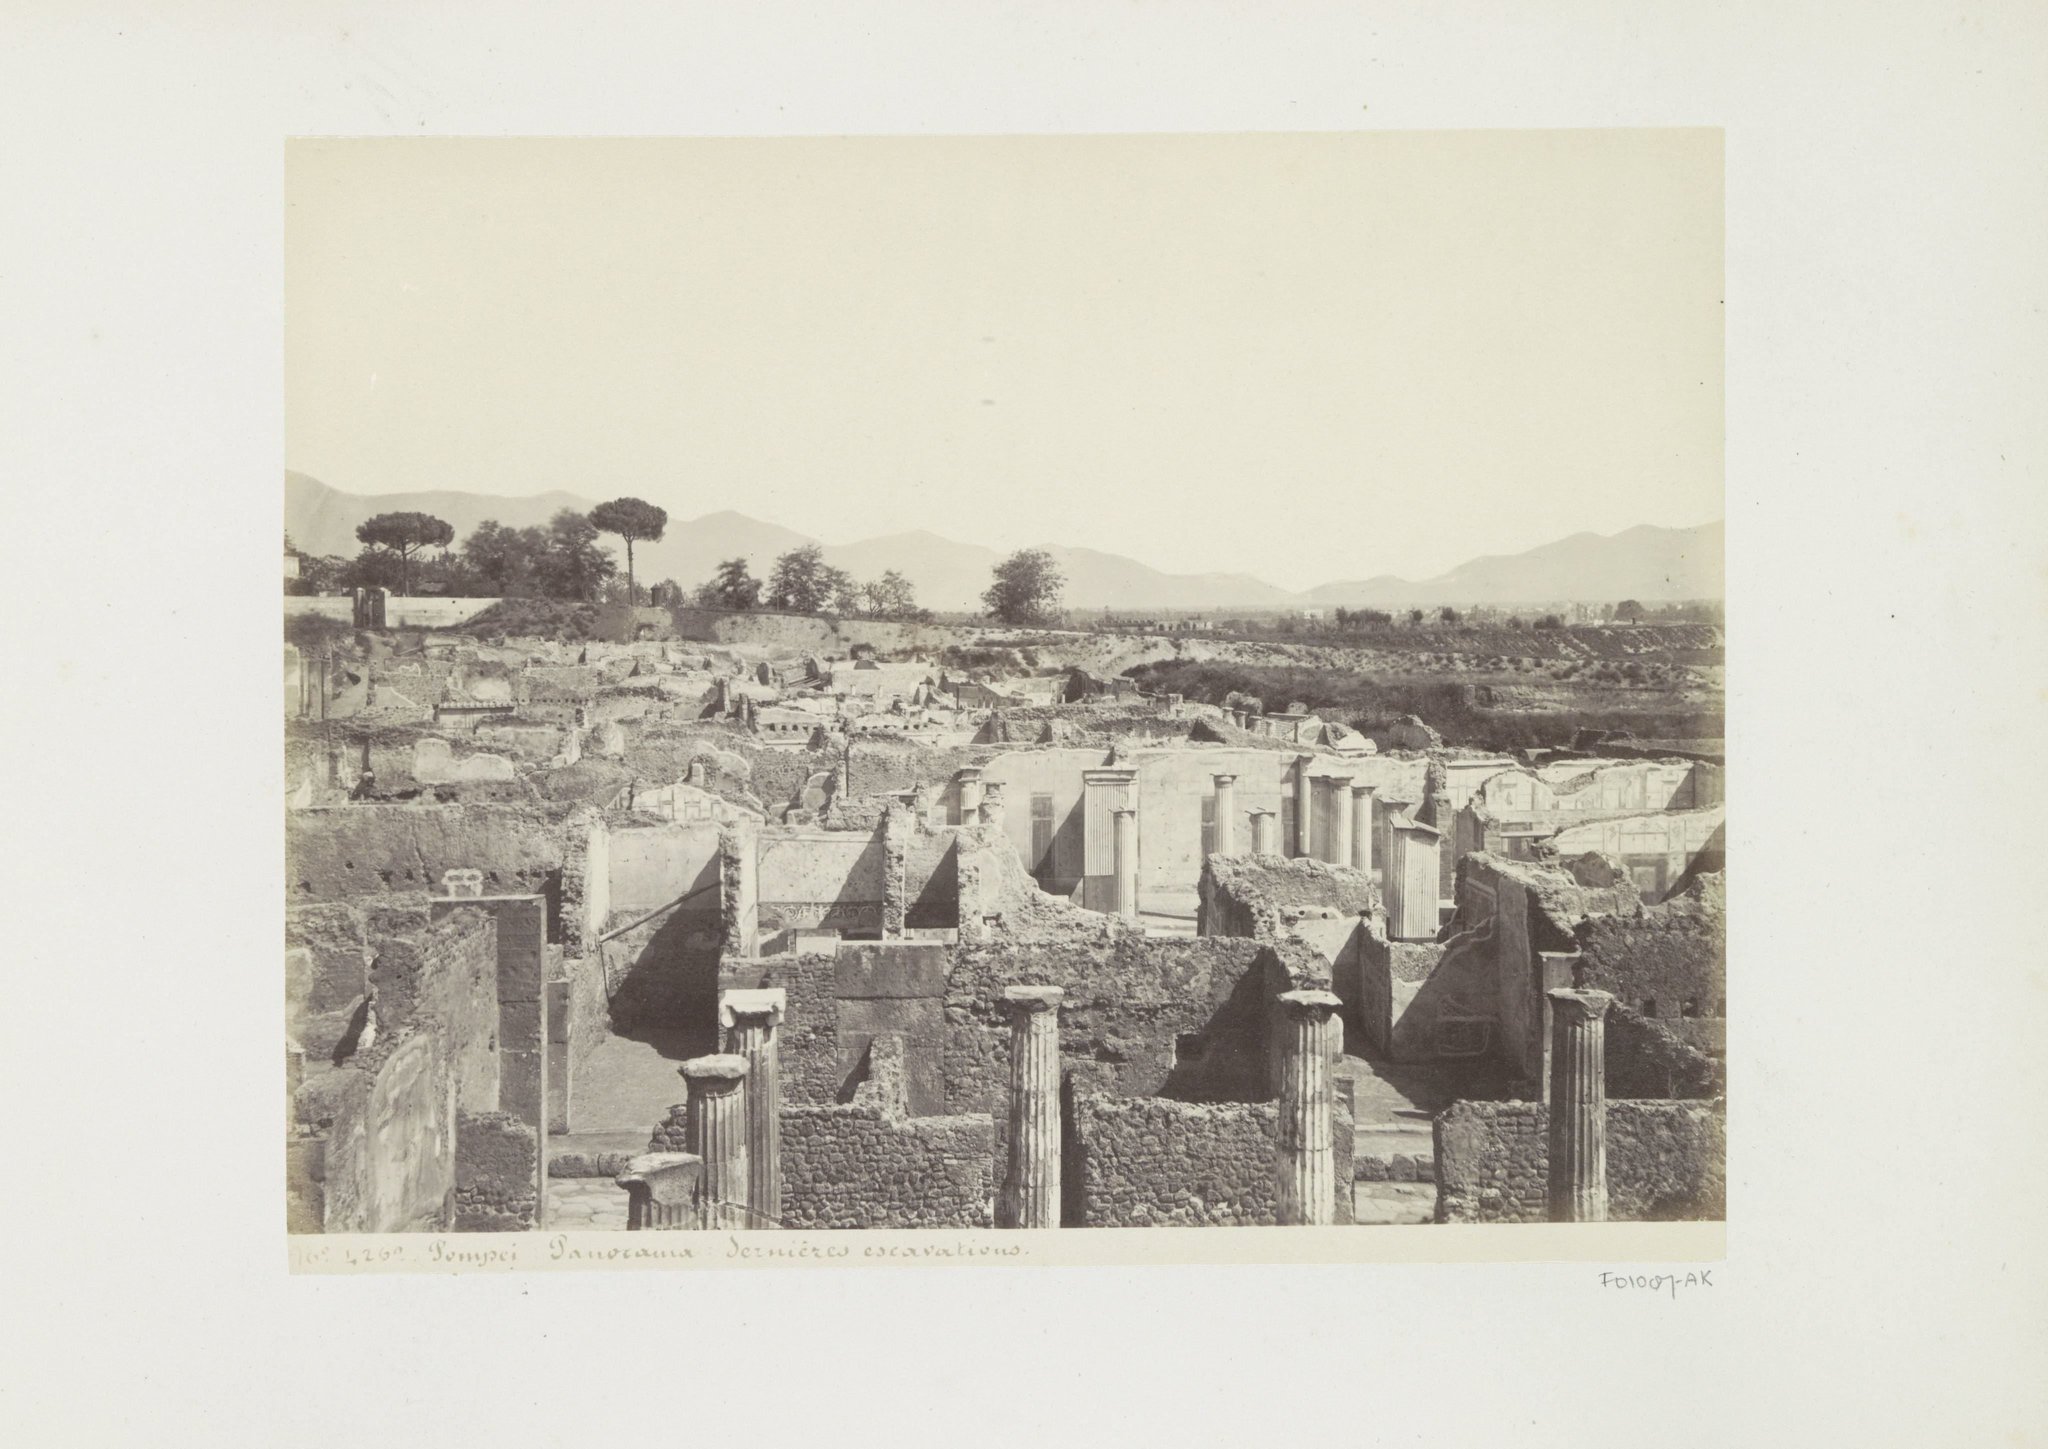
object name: photograph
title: Restanten van gebouwen in Pompeï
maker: Anonymous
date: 1865-1875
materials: paper, photographic support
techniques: albumen print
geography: pompeii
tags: excavation ~ archaeology, pompeii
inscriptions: negative number: ‘4262’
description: Onderdeel van Reisalbum met foto's van bezienswaardigheden in Napels en omgeving.